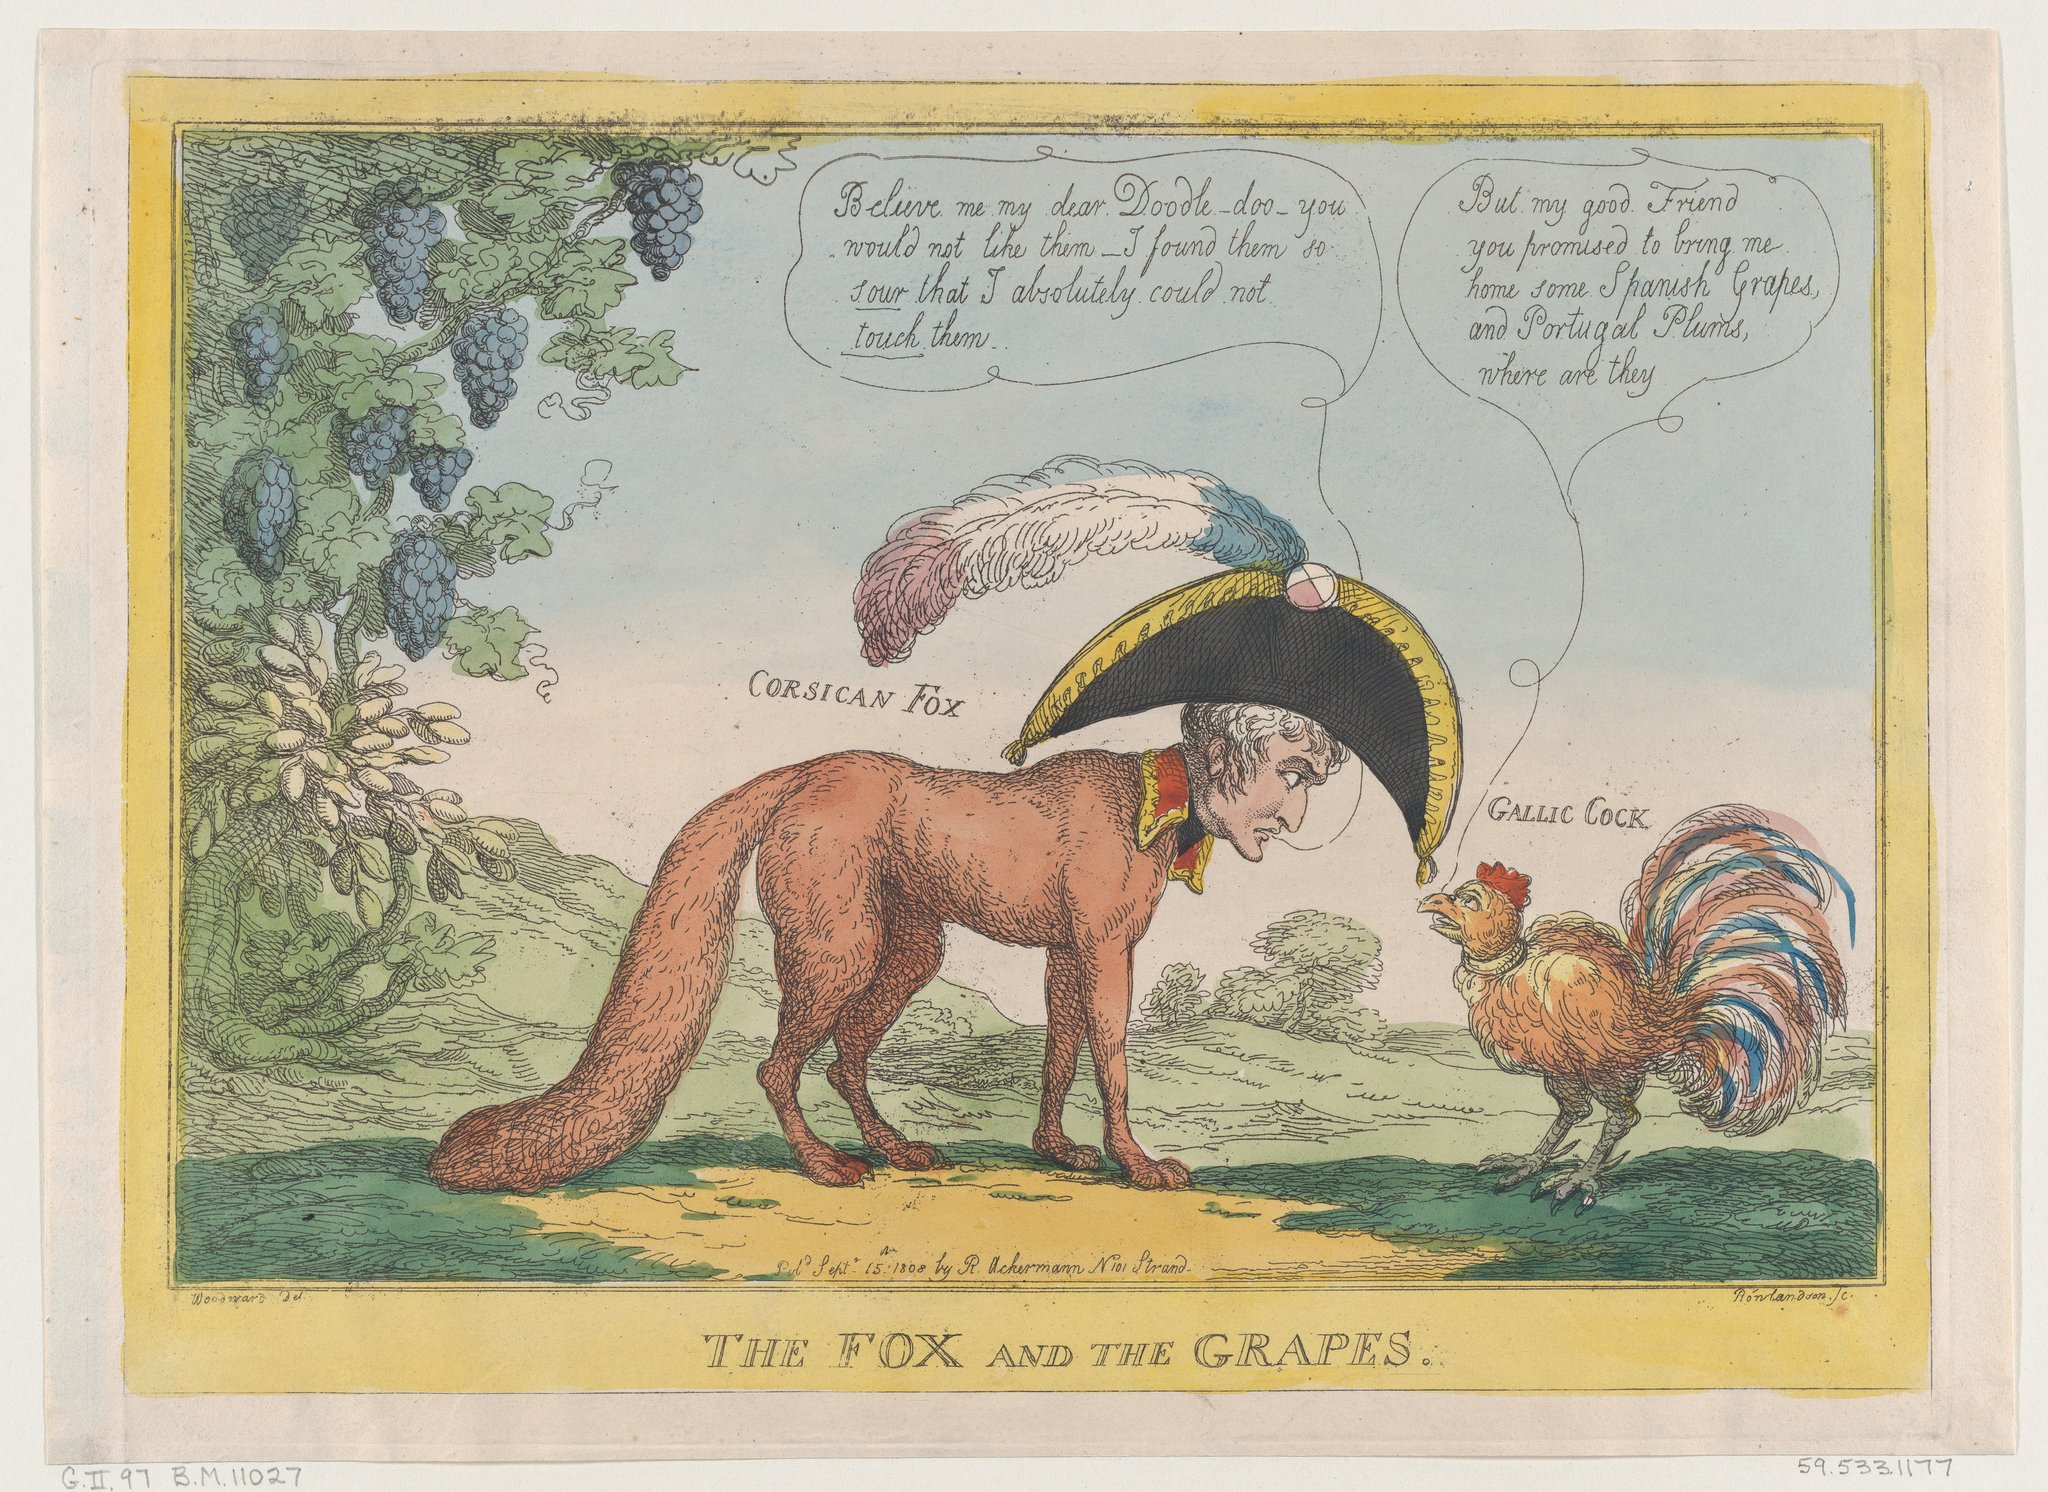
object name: print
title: The Fox and the Grapes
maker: thomas rowlandson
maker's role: artist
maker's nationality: british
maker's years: 1757-1827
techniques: etching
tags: satire,napoleon i,heads,men,roosters,foxes,politics